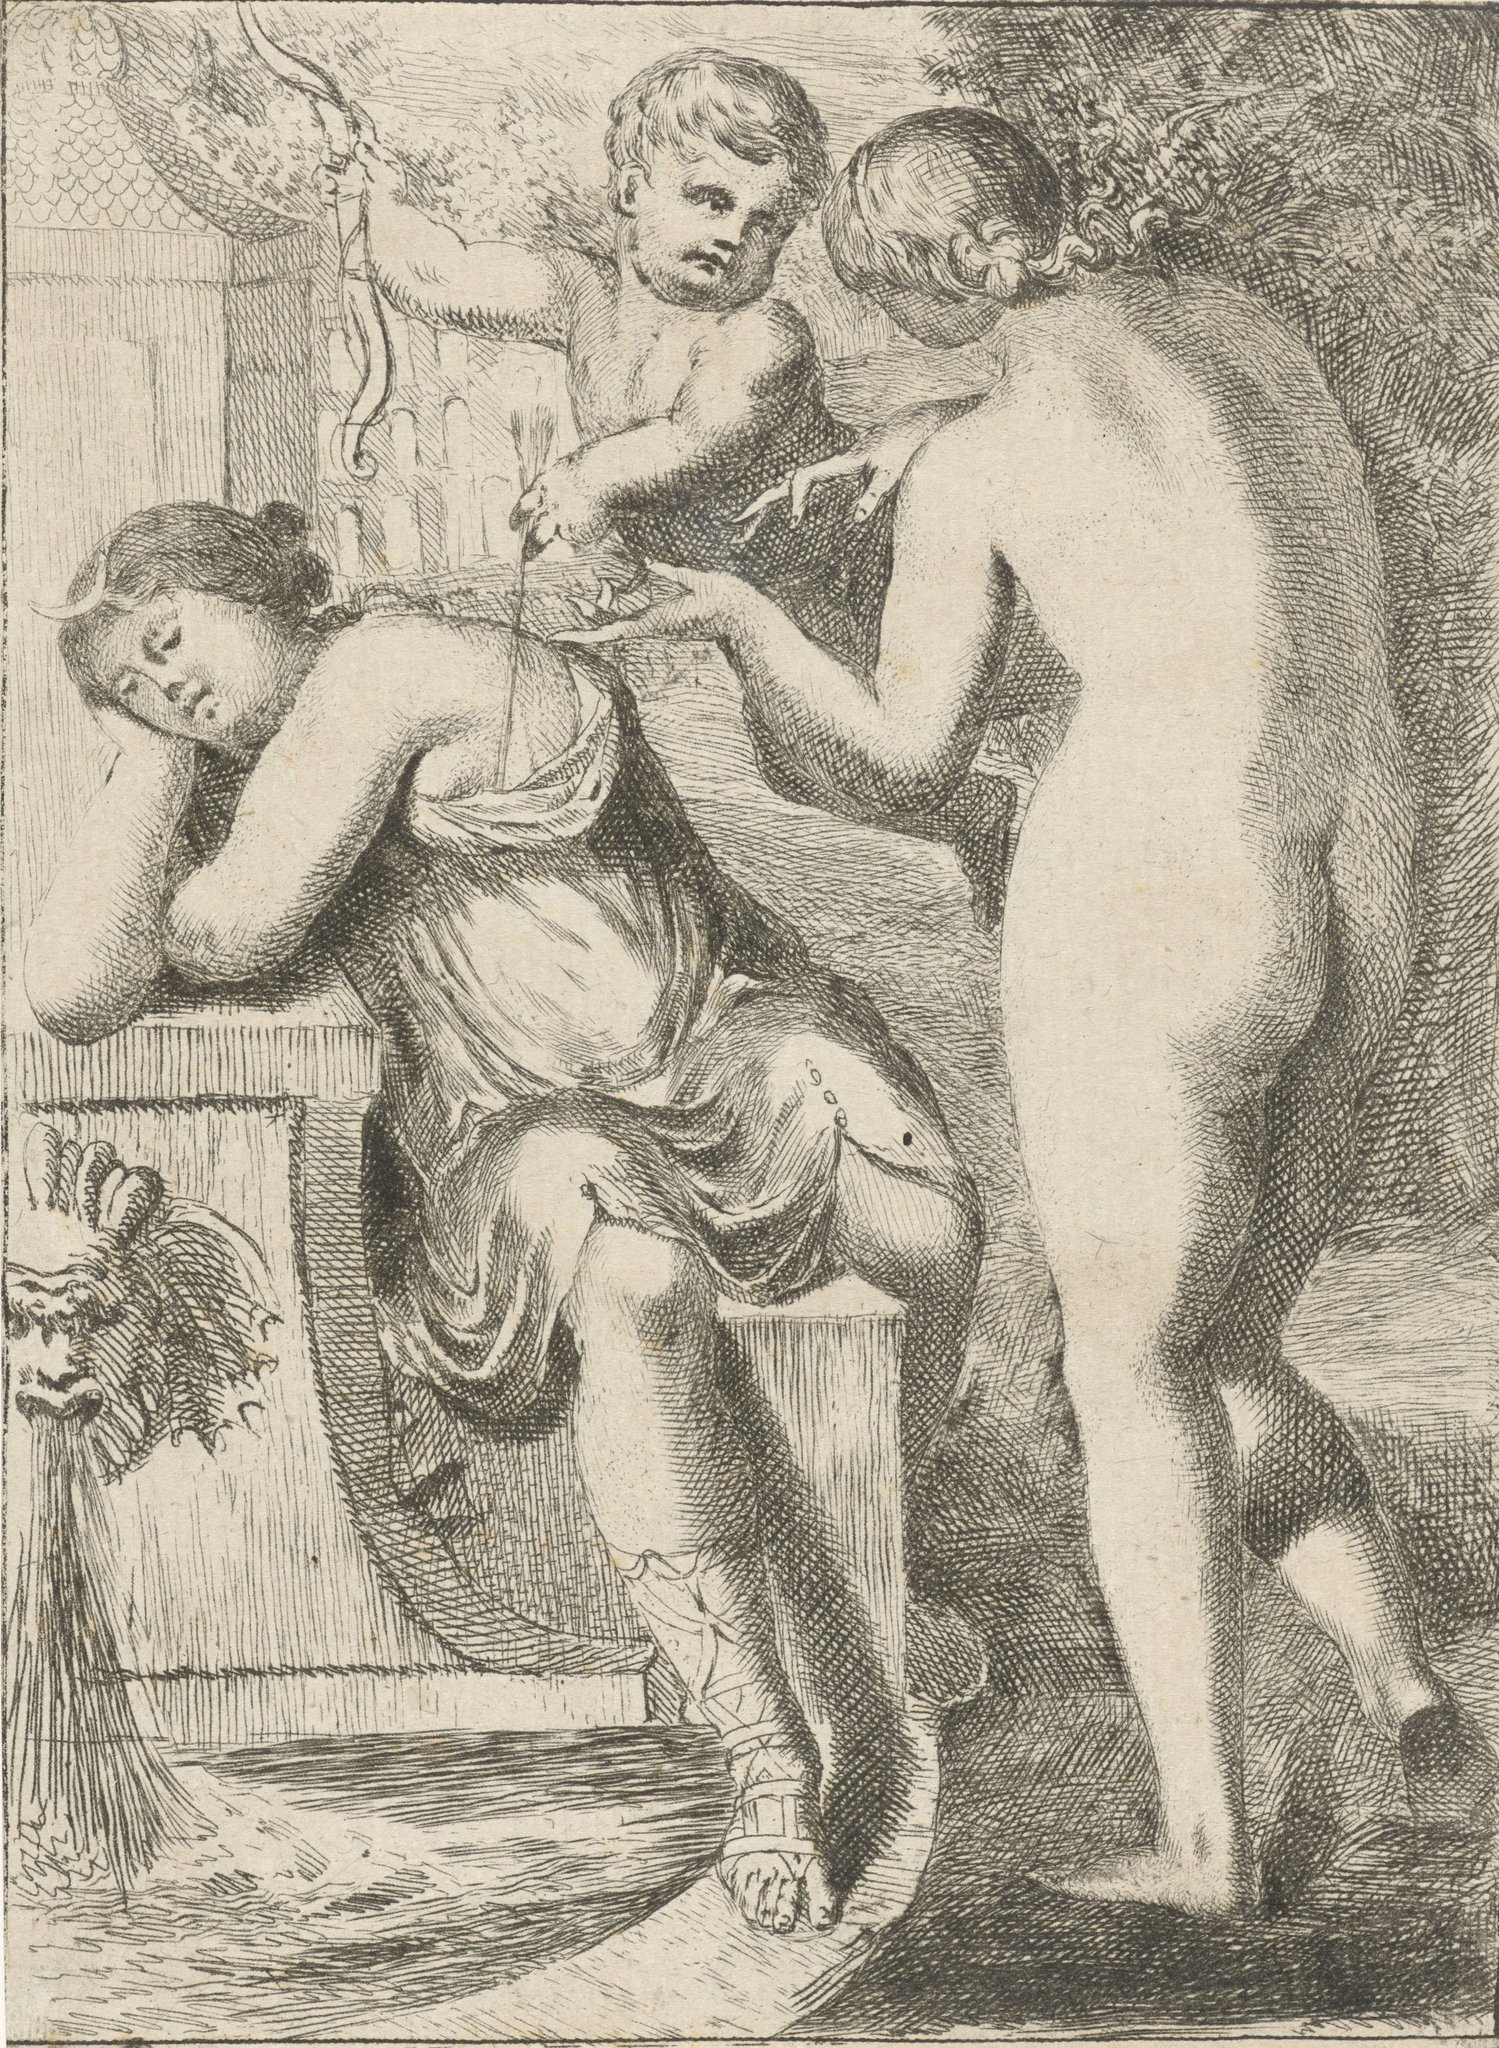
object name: print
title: Diana en Venus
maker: pieter van der plas (ii)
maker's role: print maker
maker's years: 1647-1708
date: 1687-1708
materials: paper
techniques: engraving, etching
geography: northern netherlands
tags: (story of) diana (artemis), sleeping; unconsciousness, venus and cupid (cupid not being mere attribute)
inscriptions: collector's mark: Lugt 2228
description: Diana is in slaap gevallen bij een fontein. Venus draagt Amor op zijn pijl in de jurk van Diana te steken.